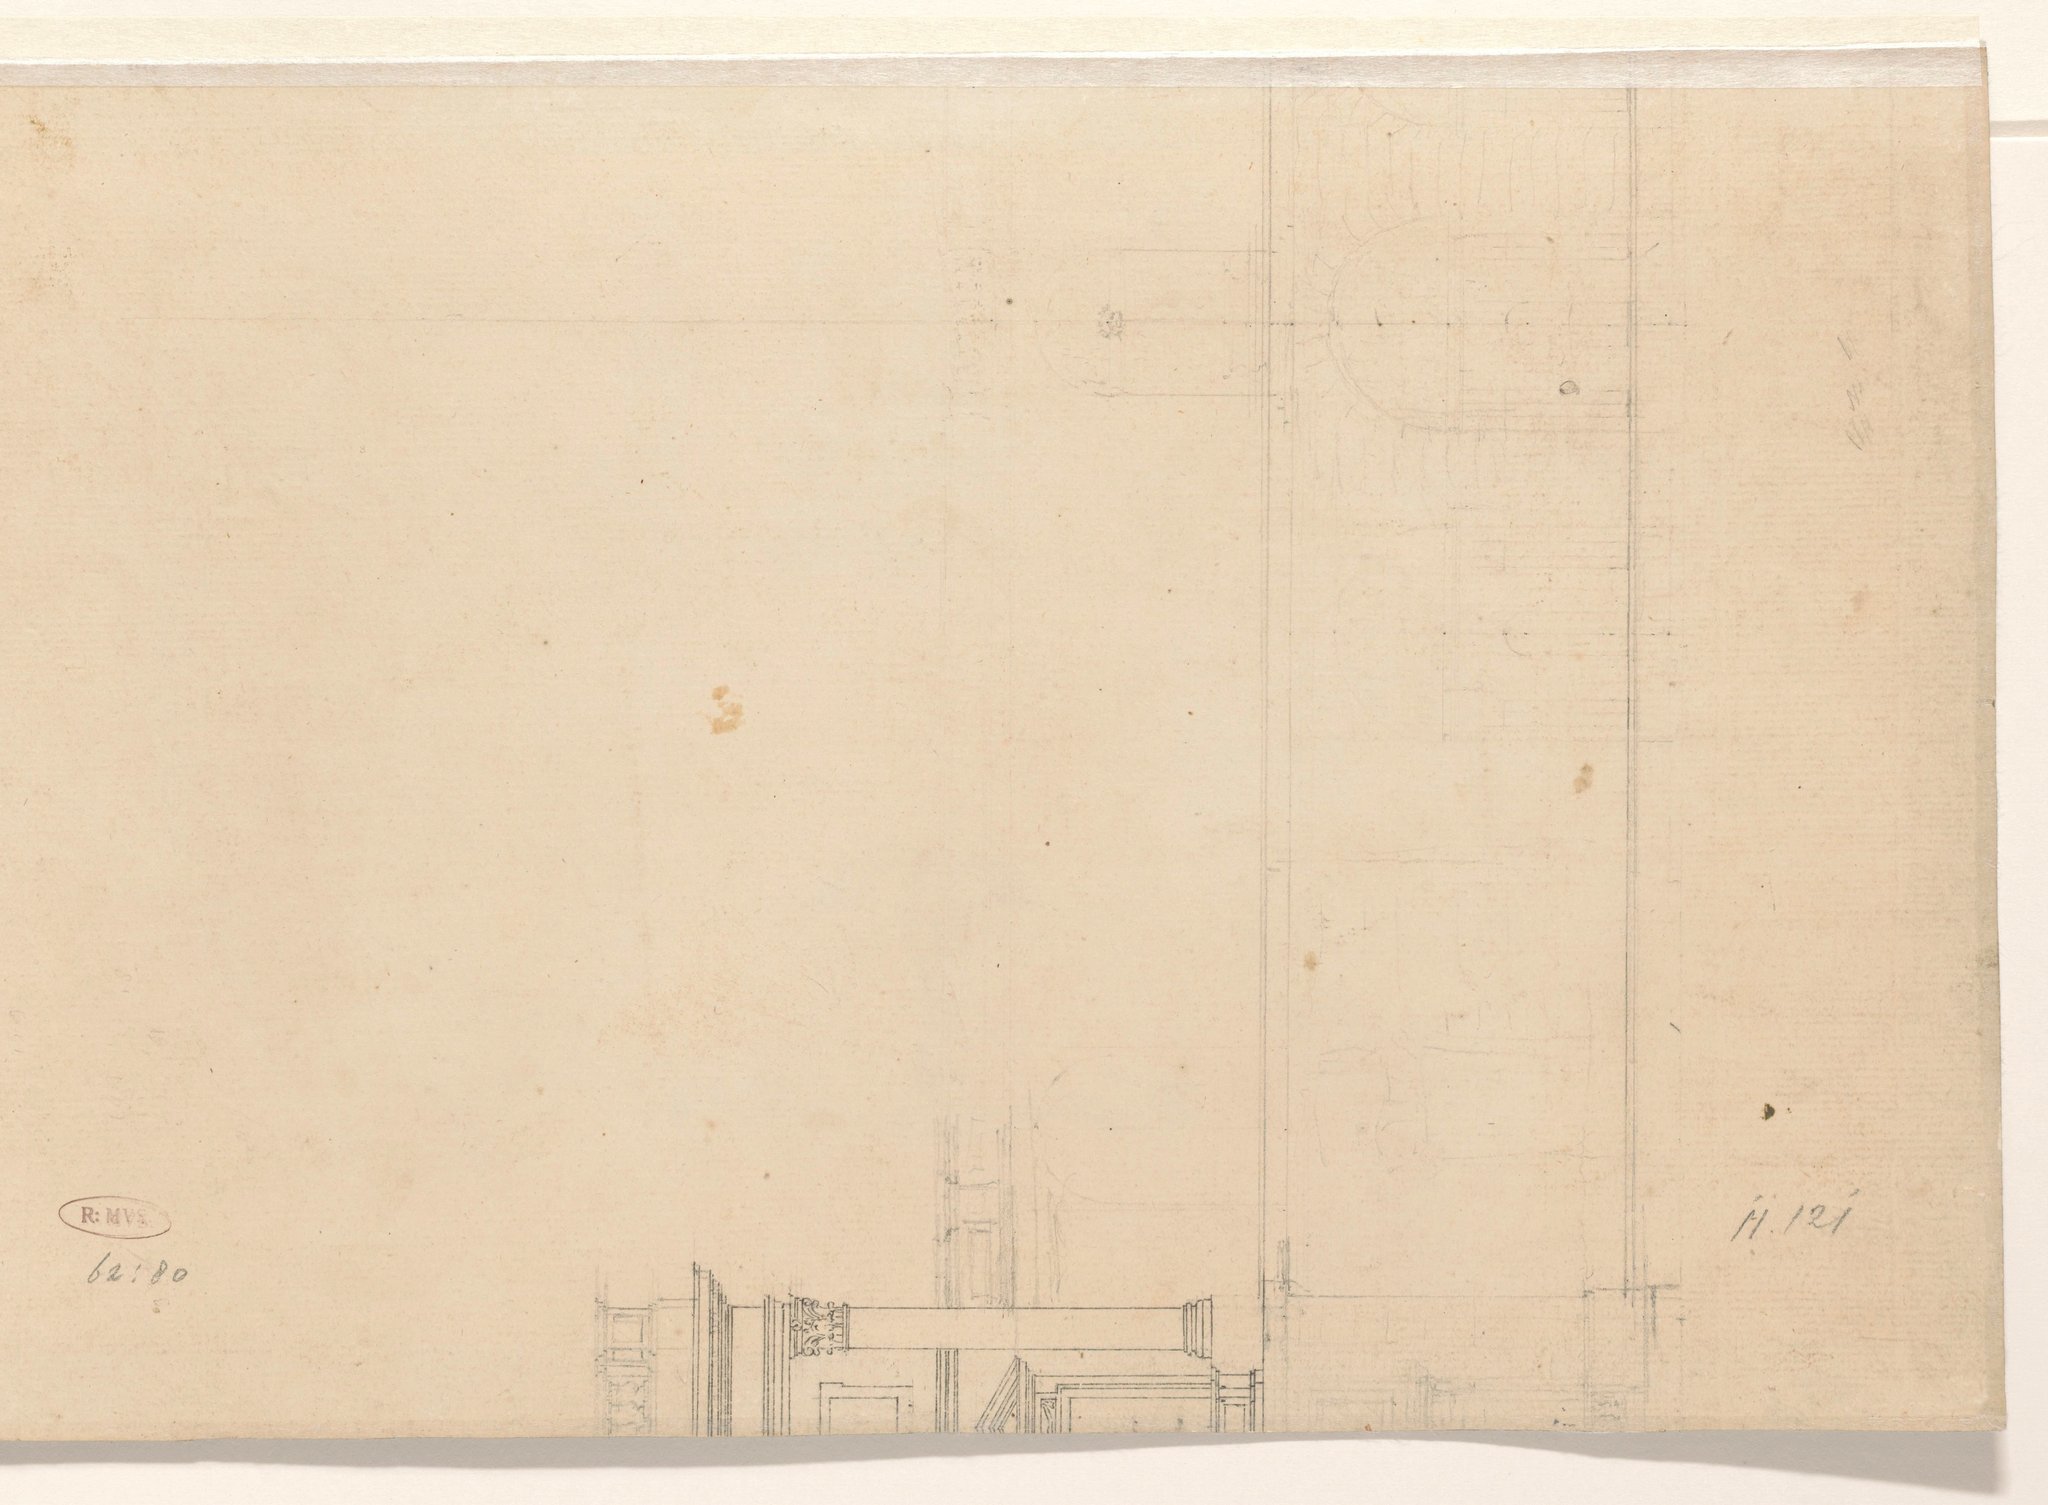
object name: drawing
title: Architectuurstudies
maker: c. kayser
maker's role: draughtsman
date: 1773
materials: ink, paper, pencil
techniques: pen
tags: exterior ~ architectural design or model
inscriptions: date